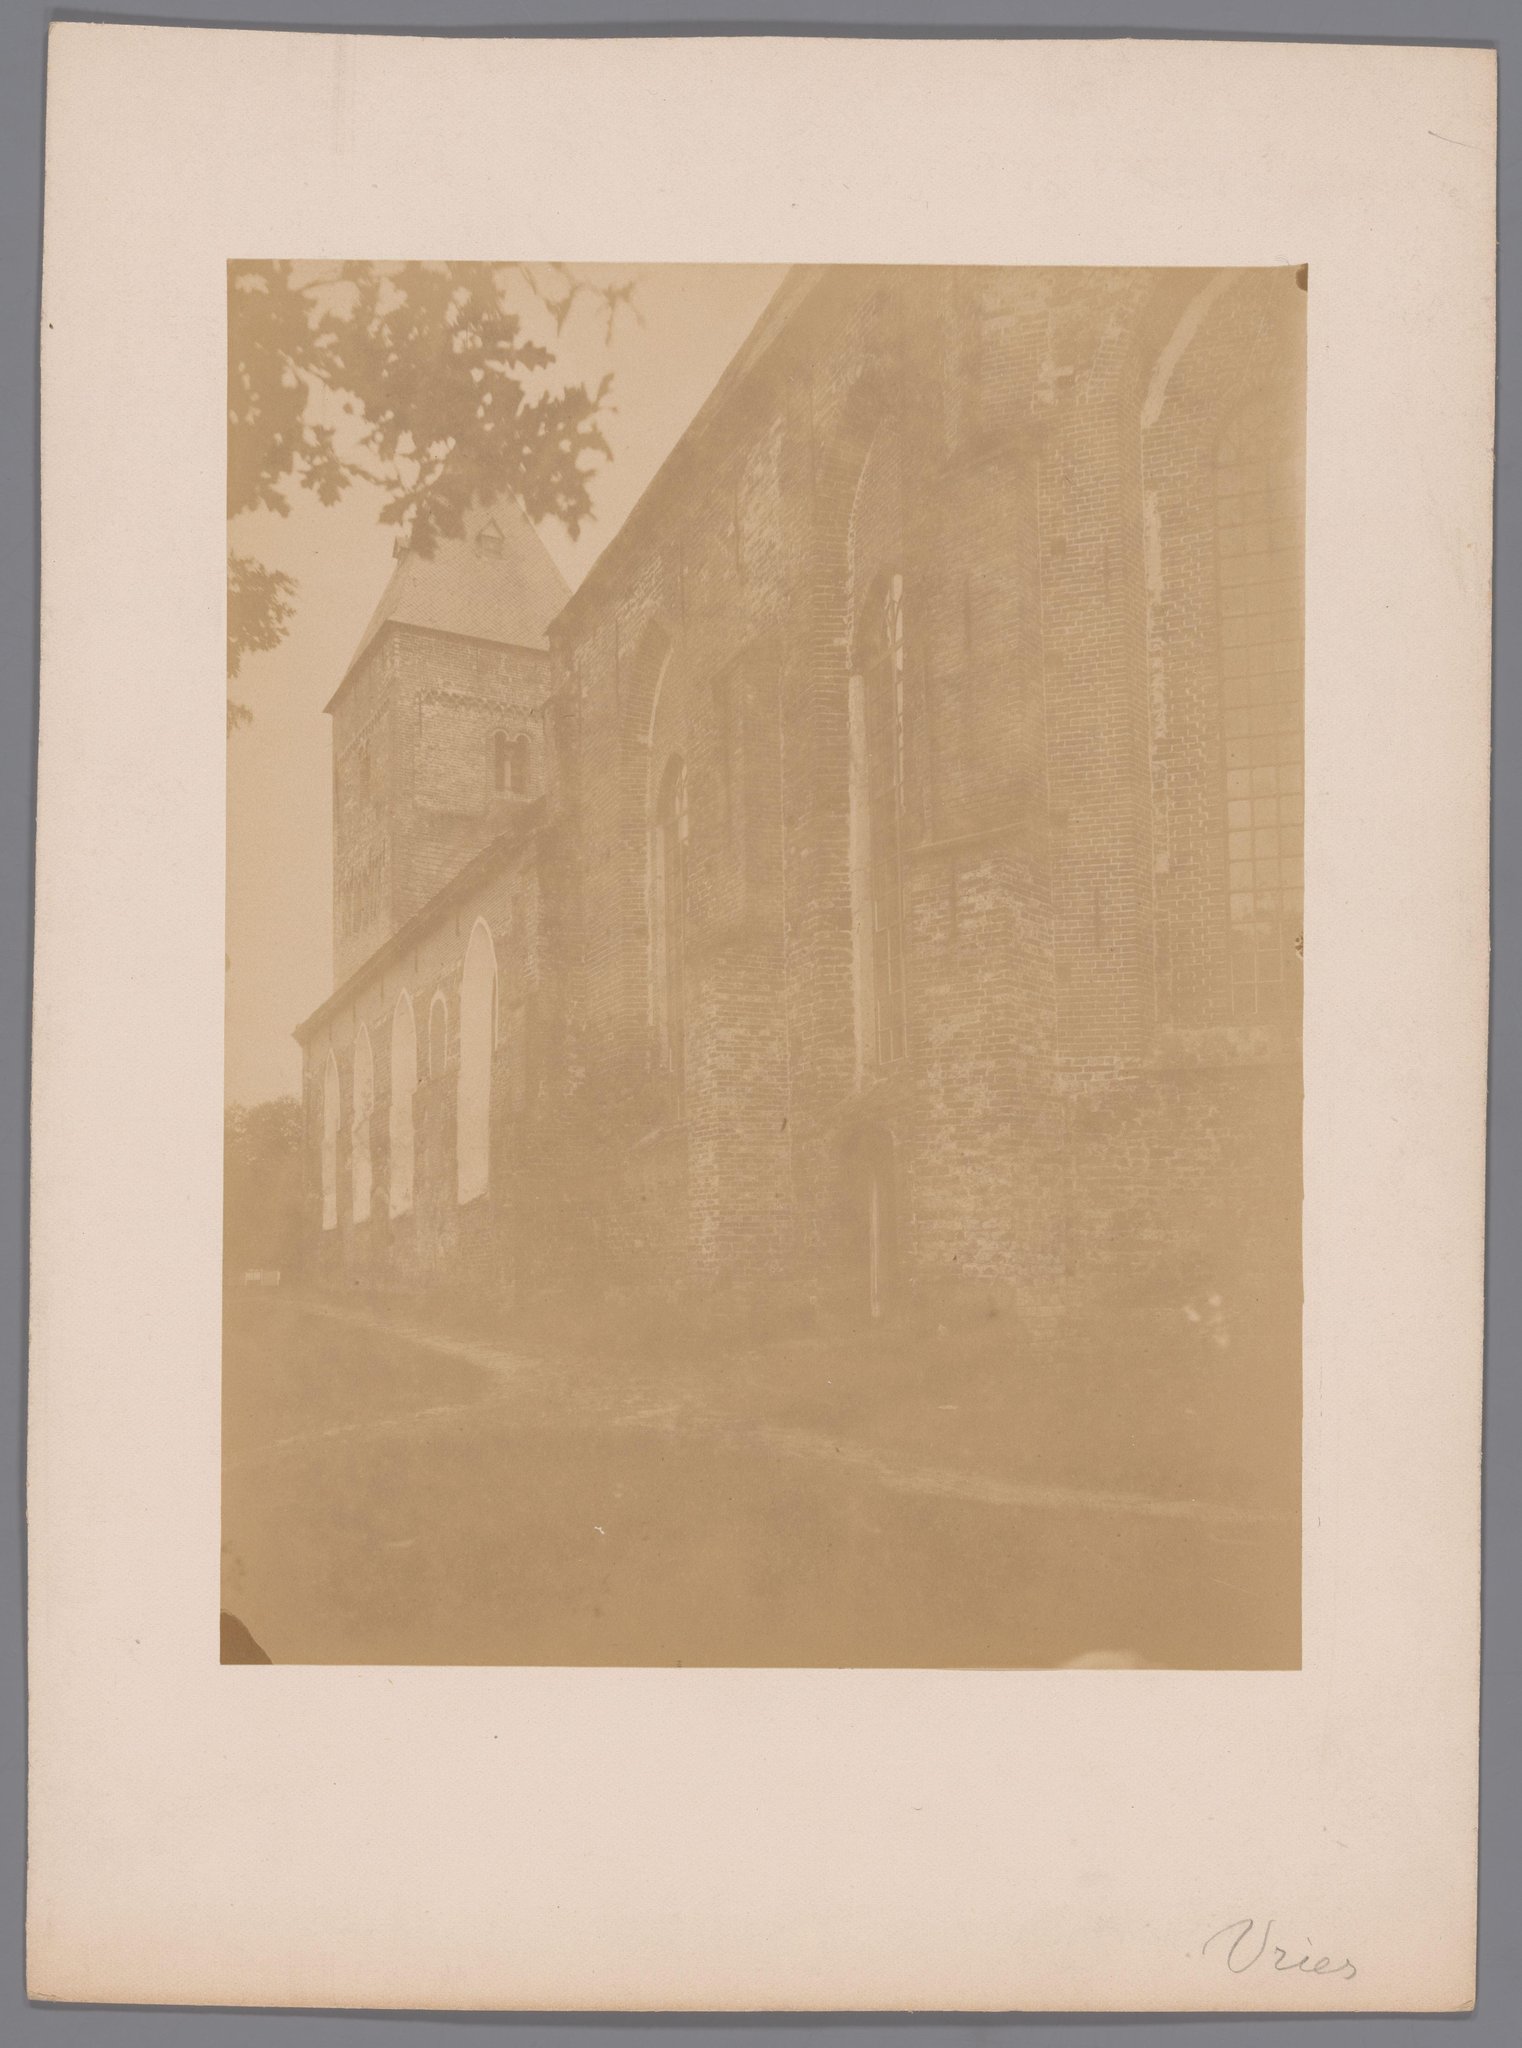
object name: photograph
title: Zuidzijde van de Sint-Bonifatiuskerk te Vries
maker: anoniem (monumentenzorg)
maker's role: fotograaf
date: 1898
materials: cardboard, photographic support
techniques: albumen print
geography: vries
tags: church (exterior)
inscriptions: annotation: ‘Vries’, annotation: ‘Kerk v/d Ned. Herv. gemeente te Vries (Drenthe)/ Aug 1898’